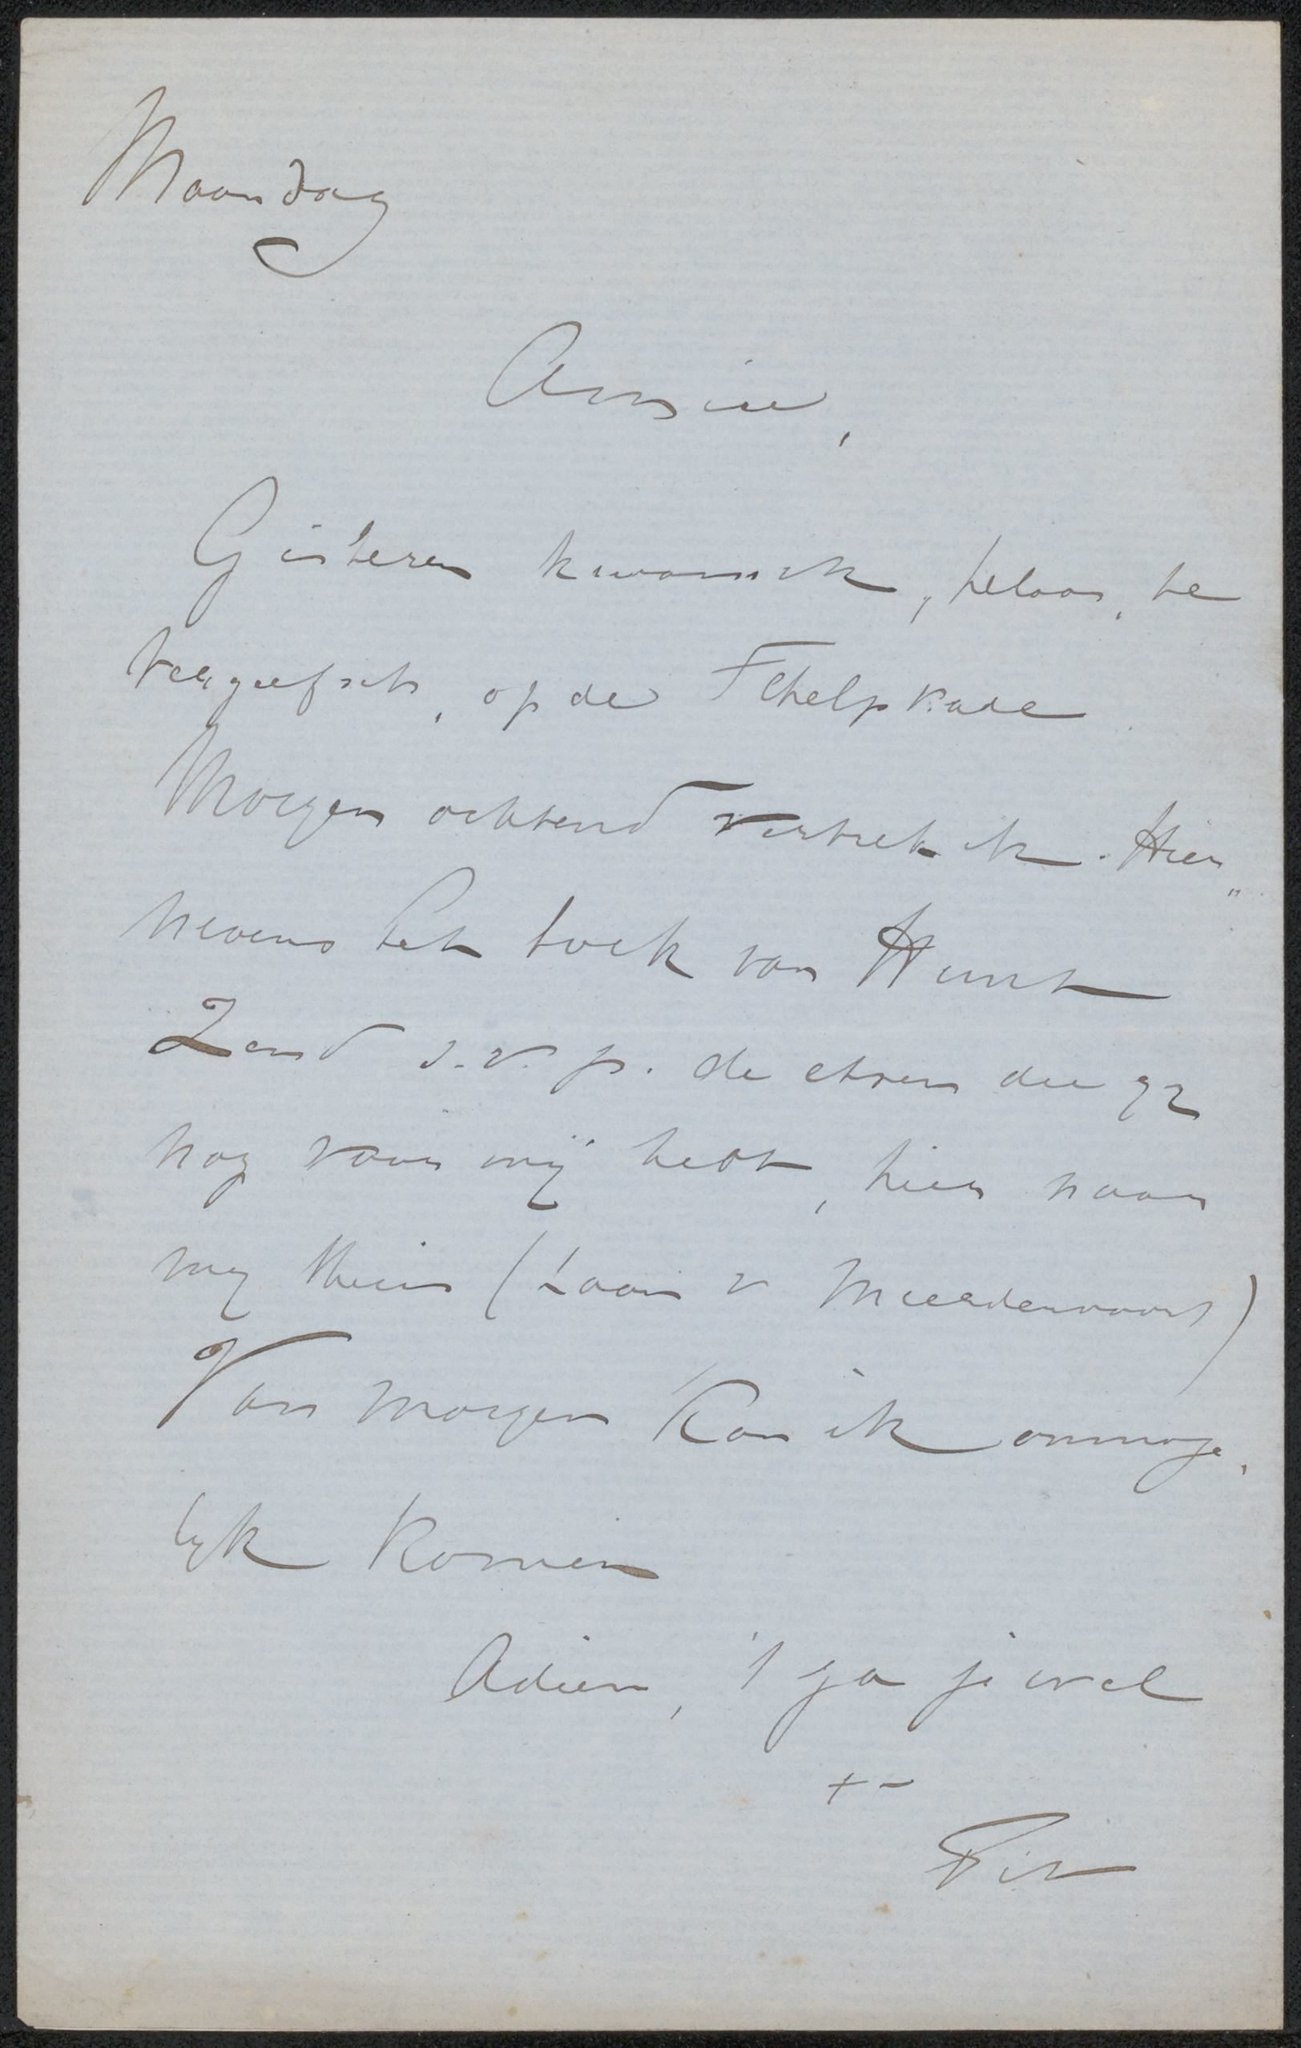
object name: letter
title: Brief aan Philip Zilcken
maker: adriaan pit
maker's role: print maker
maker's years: 1860-1944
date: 1870-1930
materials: ink, paper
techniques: pen, writing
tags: the hague, painter, draughtsman, philip zilcken, the graphic arts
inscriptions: collector's mark: ‘RPK’